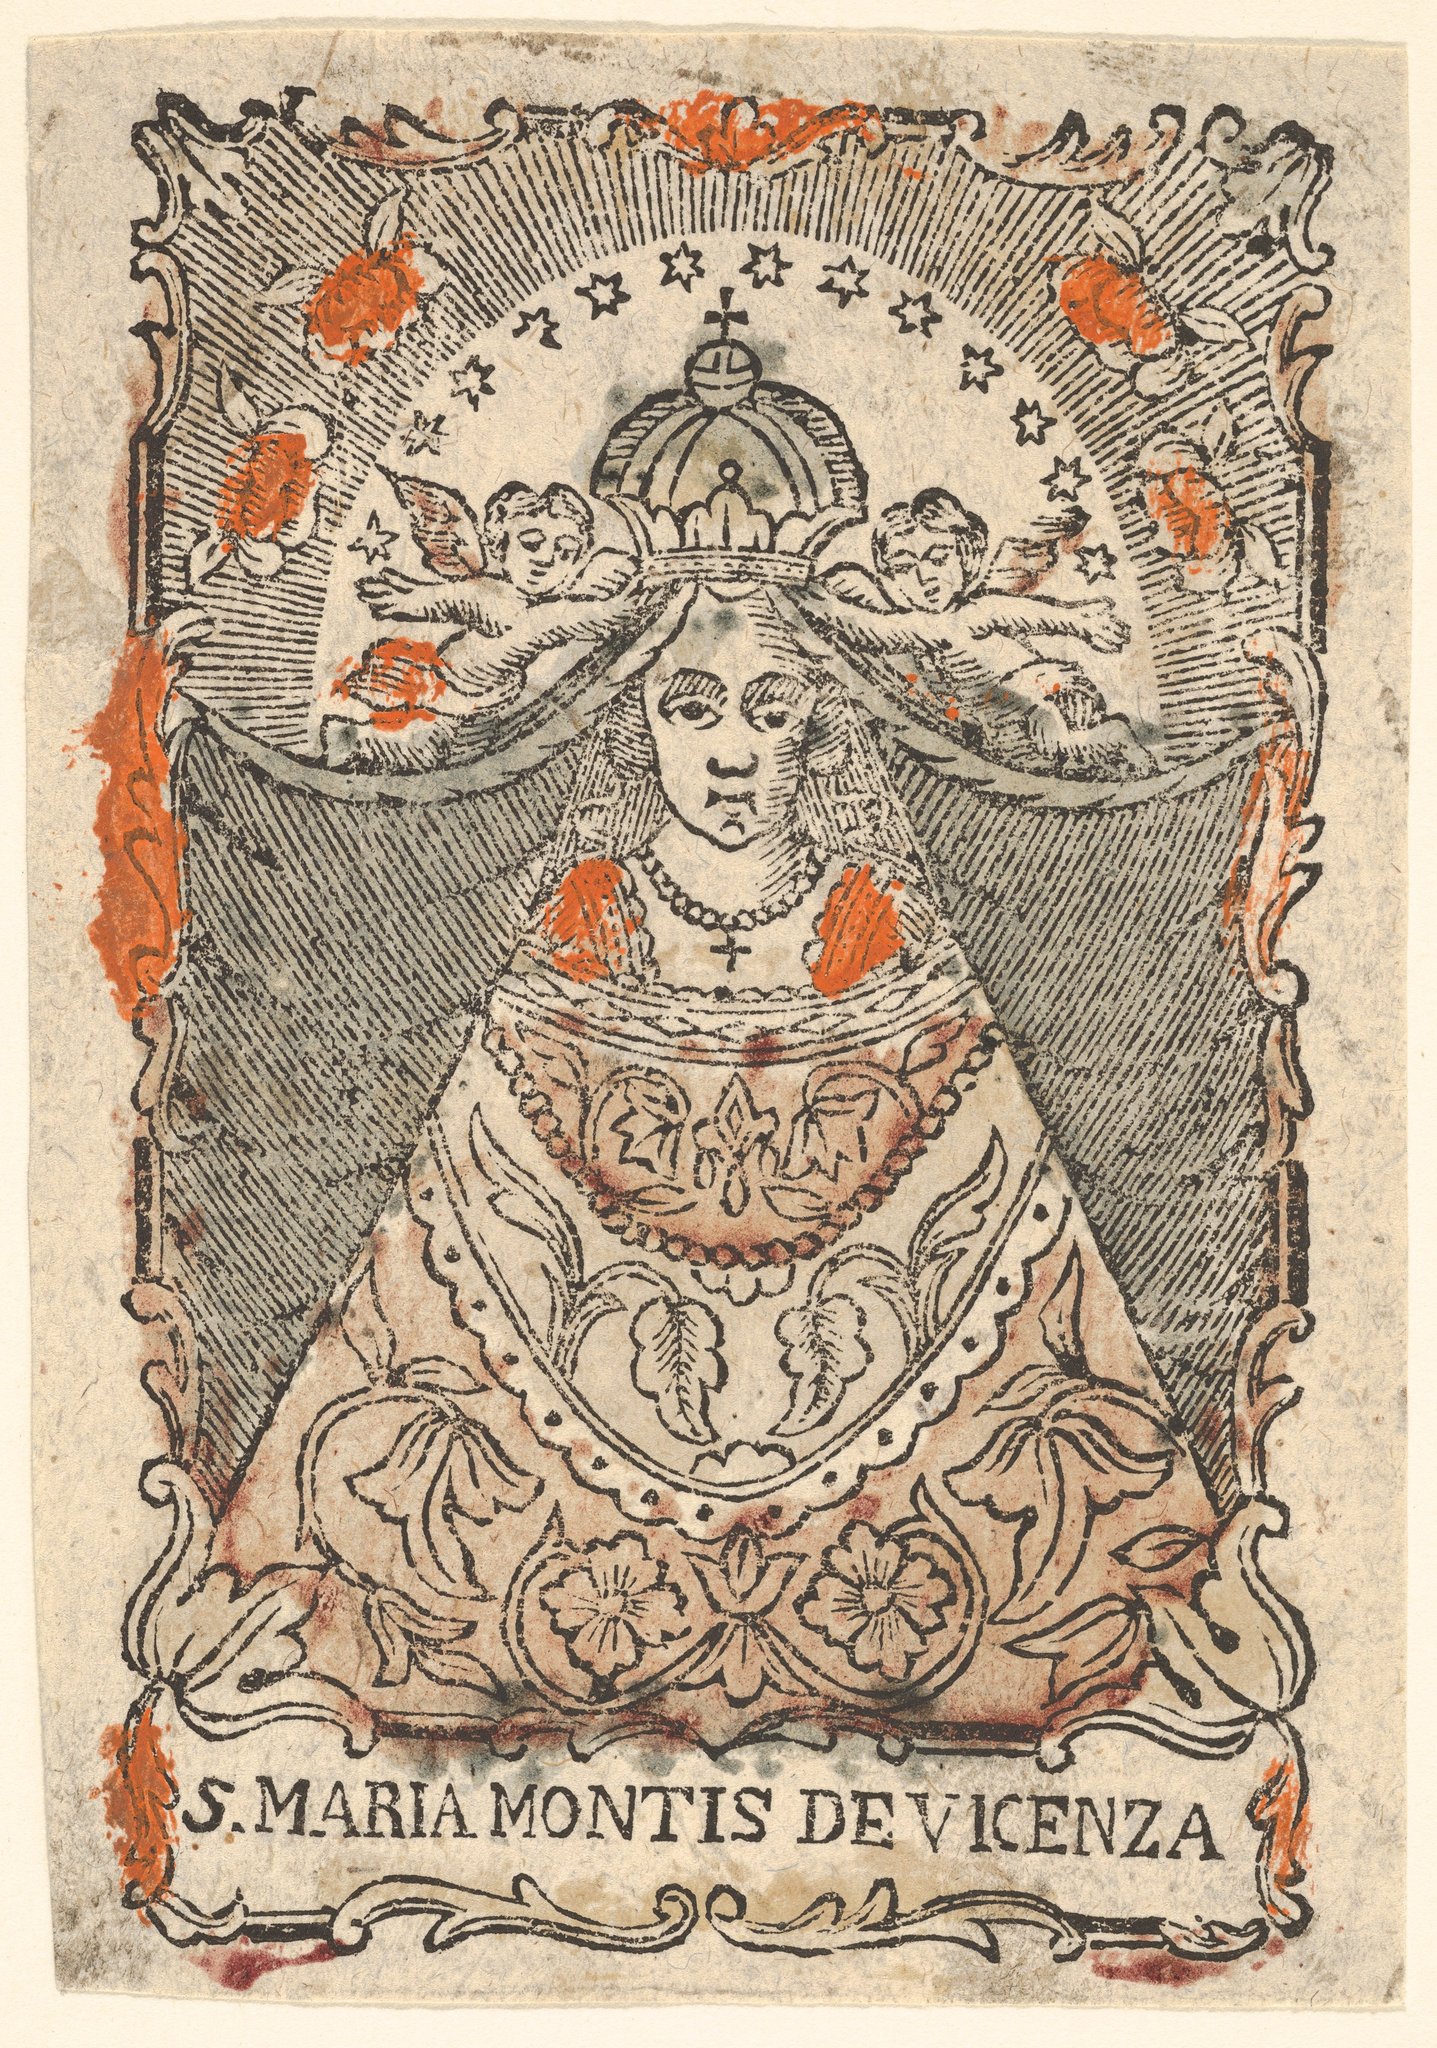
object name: print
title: Santa Maria Montis de Vicenza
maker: anonymous, italian, 17th or 18th century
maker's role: artist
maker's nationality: italian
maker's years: 1600-1799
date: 1601-1800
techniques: hand coloring, woodcut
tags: women